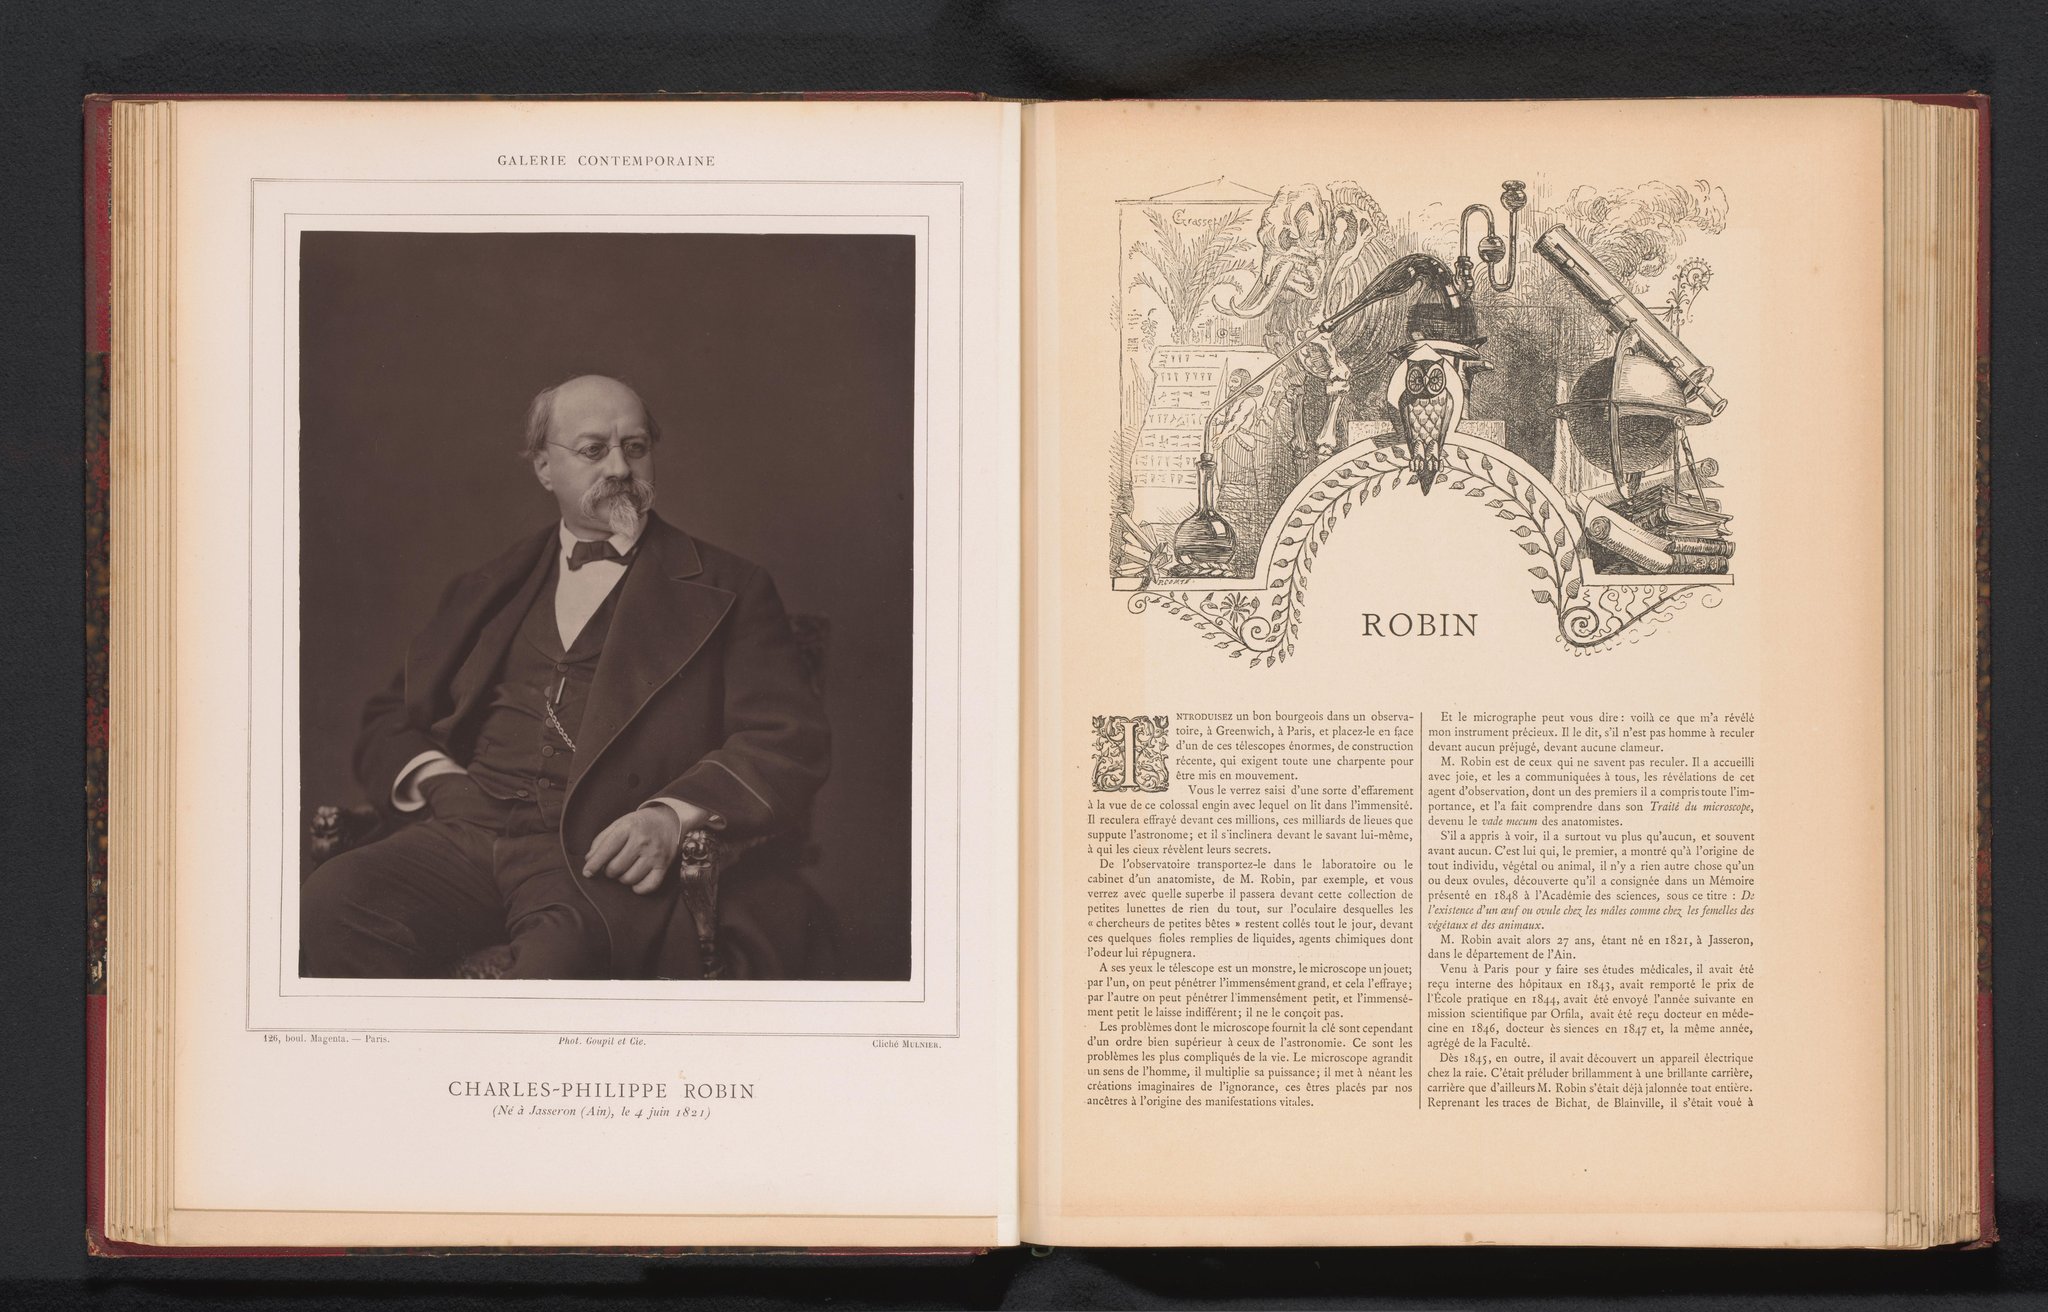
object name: photomechanical print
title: Charles-Philippe Robin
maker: ferdinand mulnier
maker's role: painter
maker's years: 1817-1891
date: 1874-1879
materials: paper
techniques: woodburytype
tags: politician, adult man, historical persons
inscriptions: inscription: ‘Galerie Contemporaine/ 126, boul. Magenta. - Paris. (Né a Jasseron (Ain), le 4 juin 1821)’